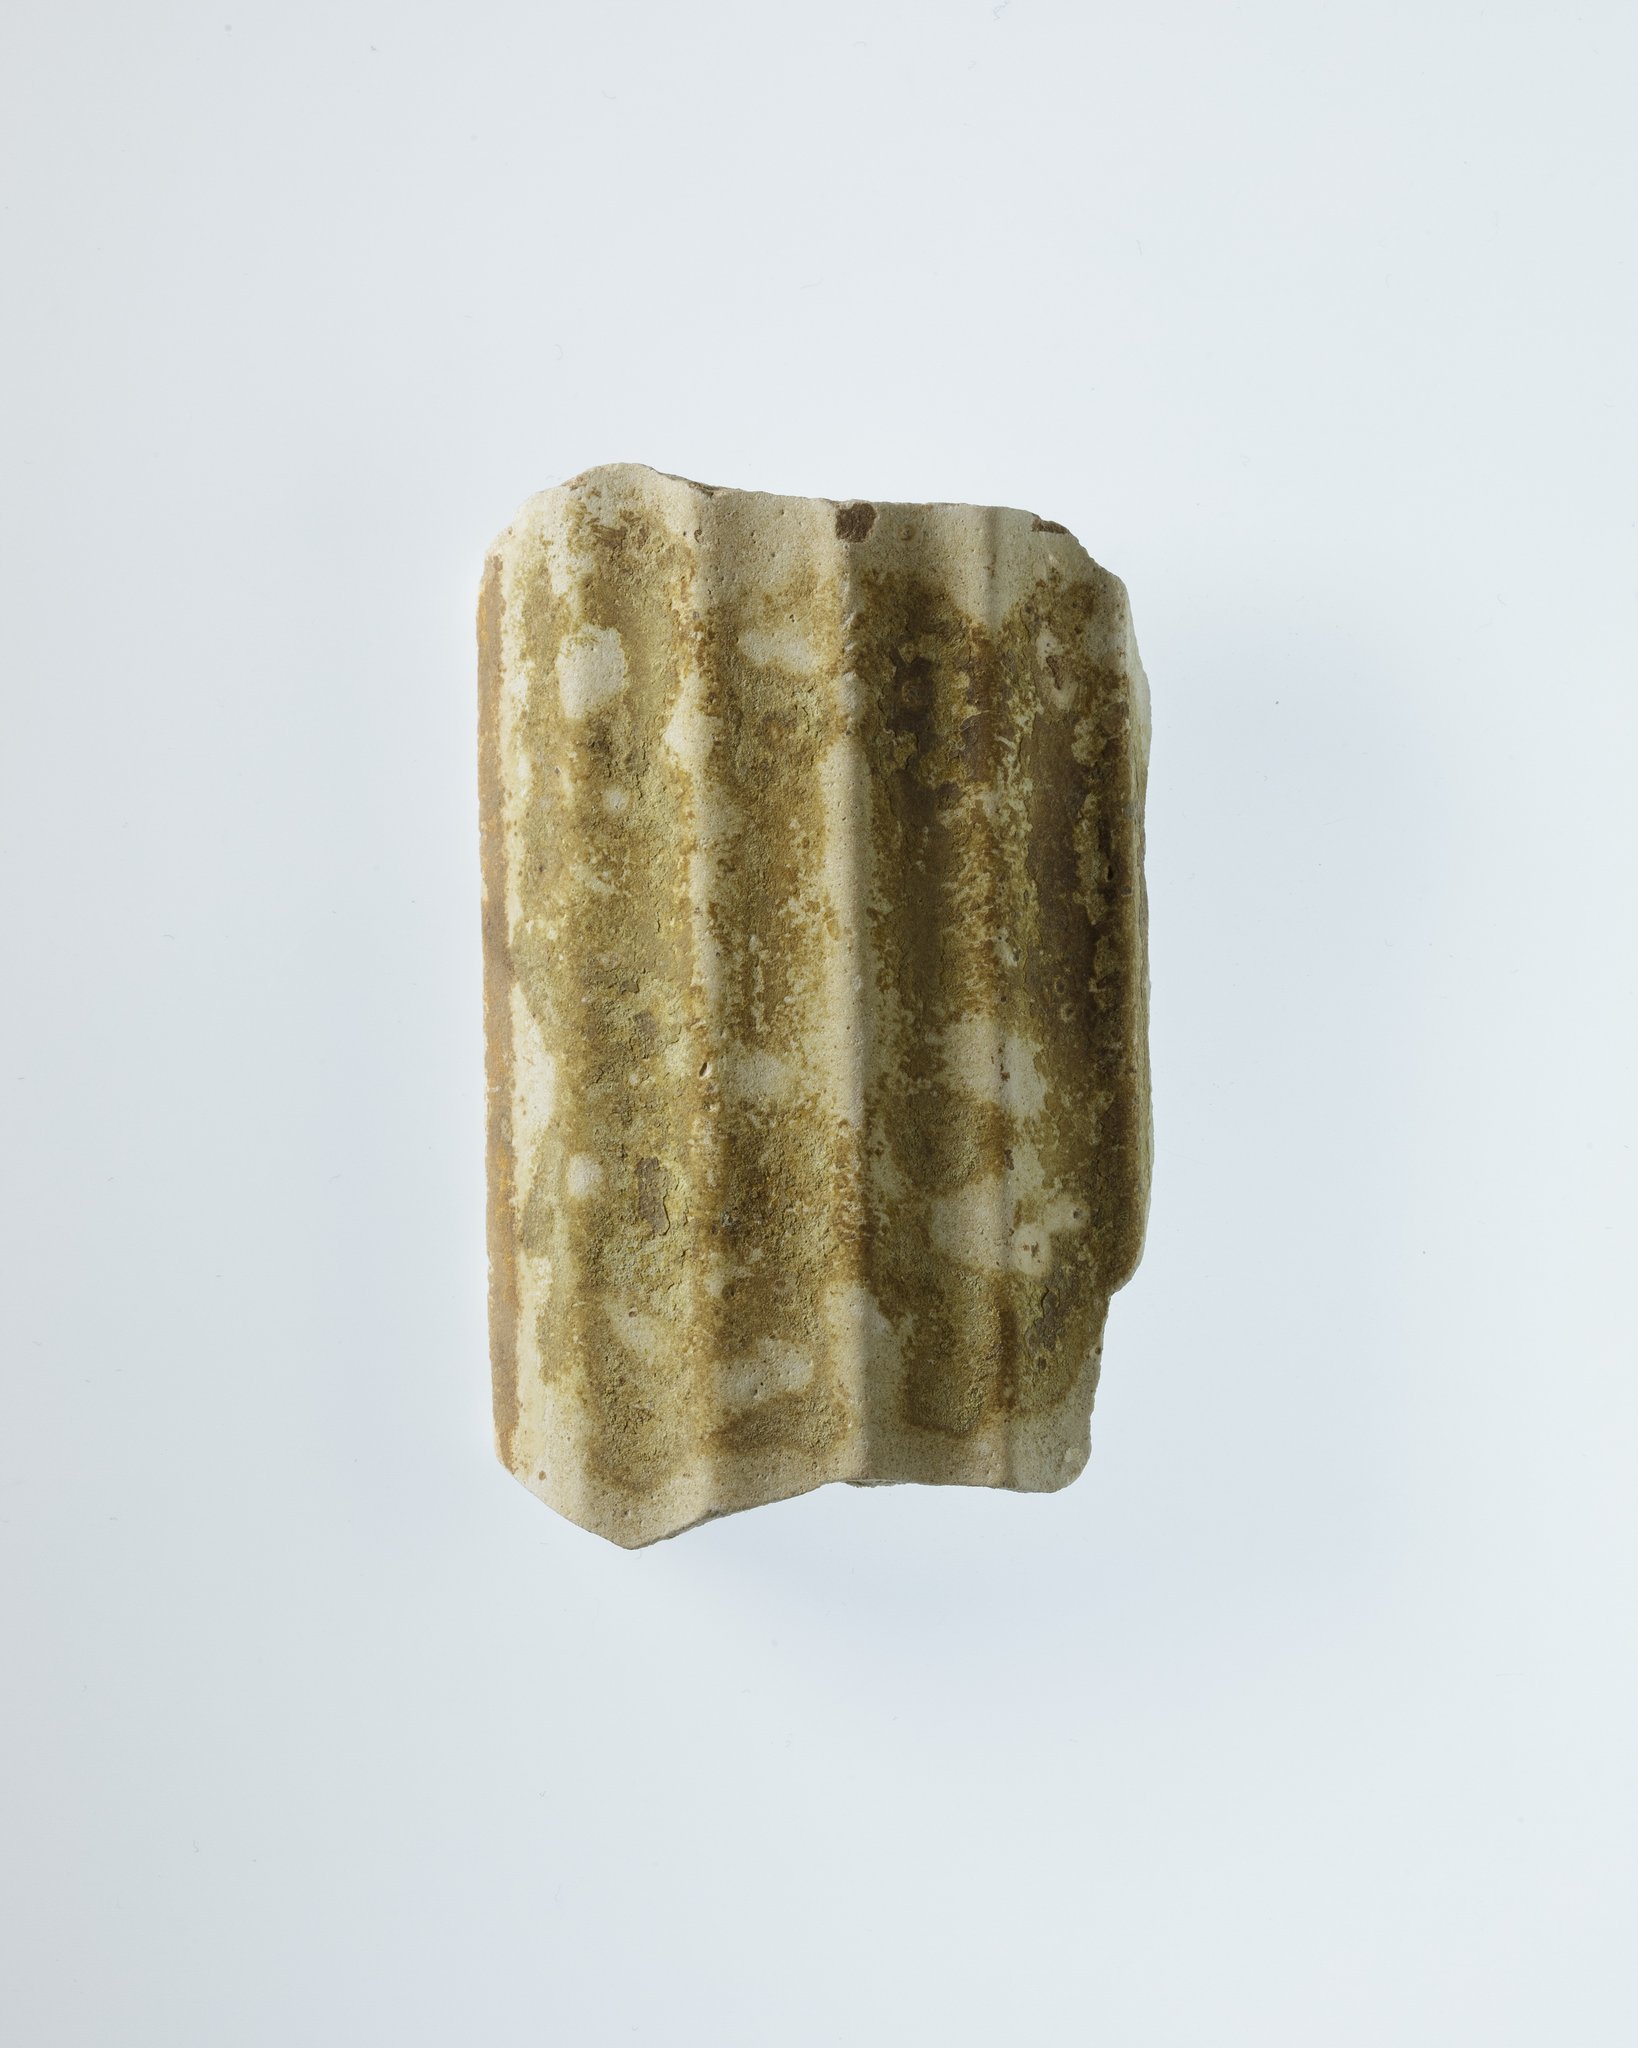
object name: vase fragment, fluted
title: Vase fragment ?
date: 1981-1640 BCE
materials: faience, glaze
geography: egypt